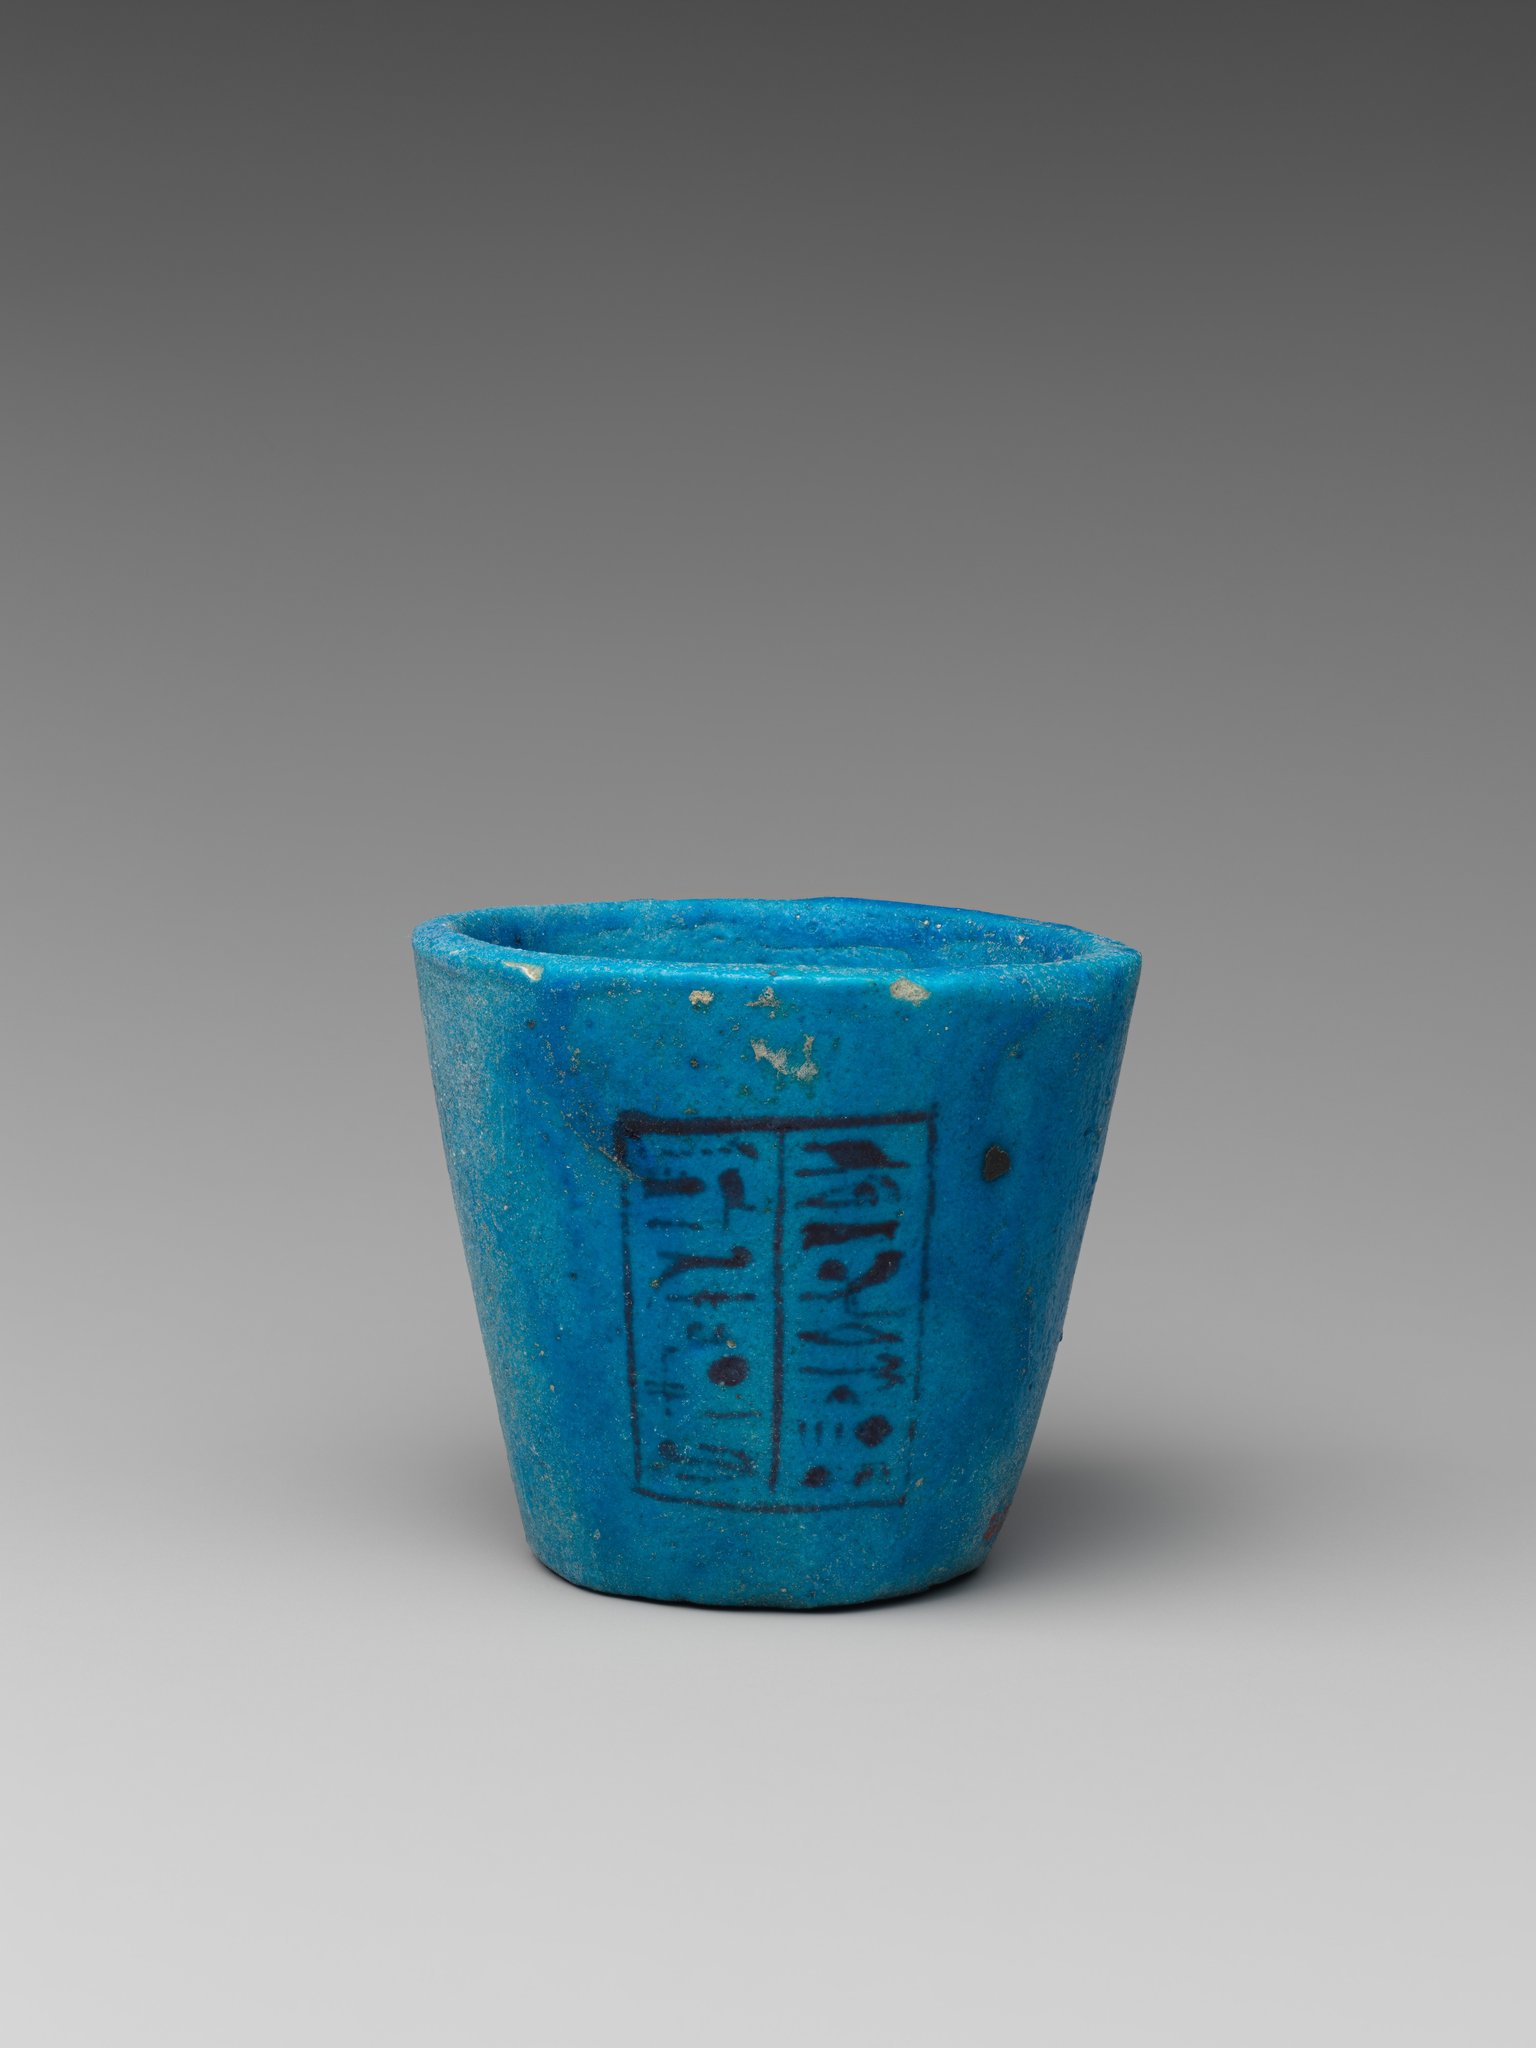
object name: cup, nesikhonsu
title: Cup of Nesikhonsu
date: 990-969 BCE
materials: faience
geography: upper egypt, thebes